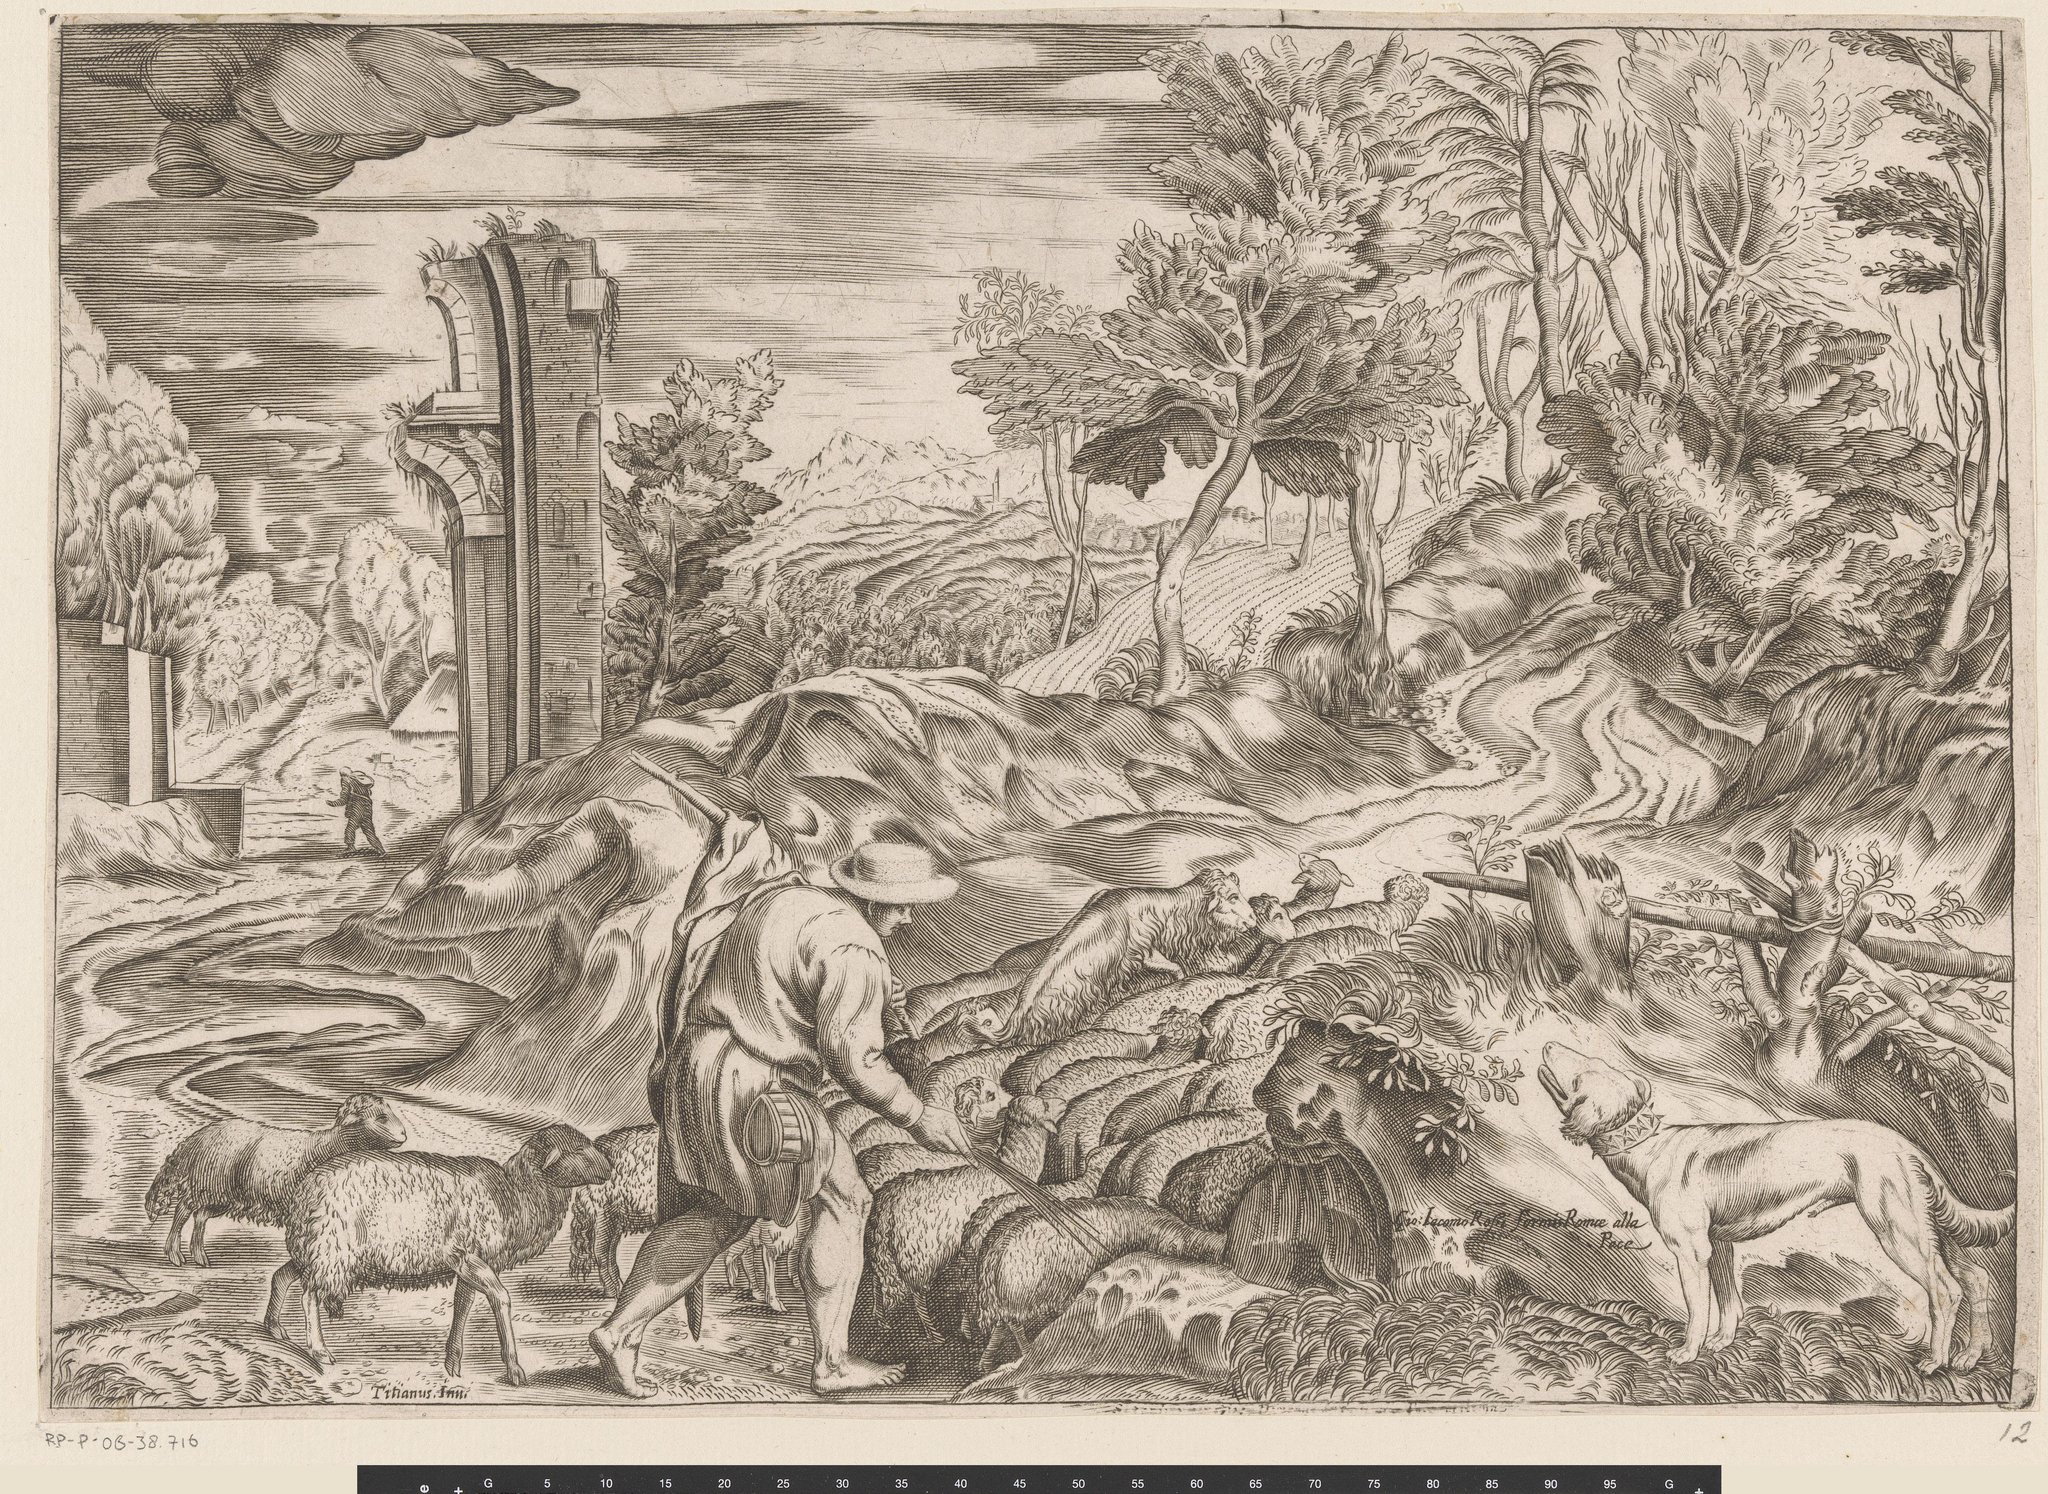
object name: print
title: Herder met kudde schapen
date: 1637-1691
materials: paper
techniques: engraving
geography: rome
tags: landscape with ruins, herd, flock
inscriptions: collector's mark: Lugt 240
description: Een jonge herder met zomerhoed leidt zijn kudde schapen op een heuvel. Zijn hond kijkt toe op de voorgrond rechts. Op de achtergrond rechts een bosrijke heuvel en links een antieke ruïne en een wandelaar.